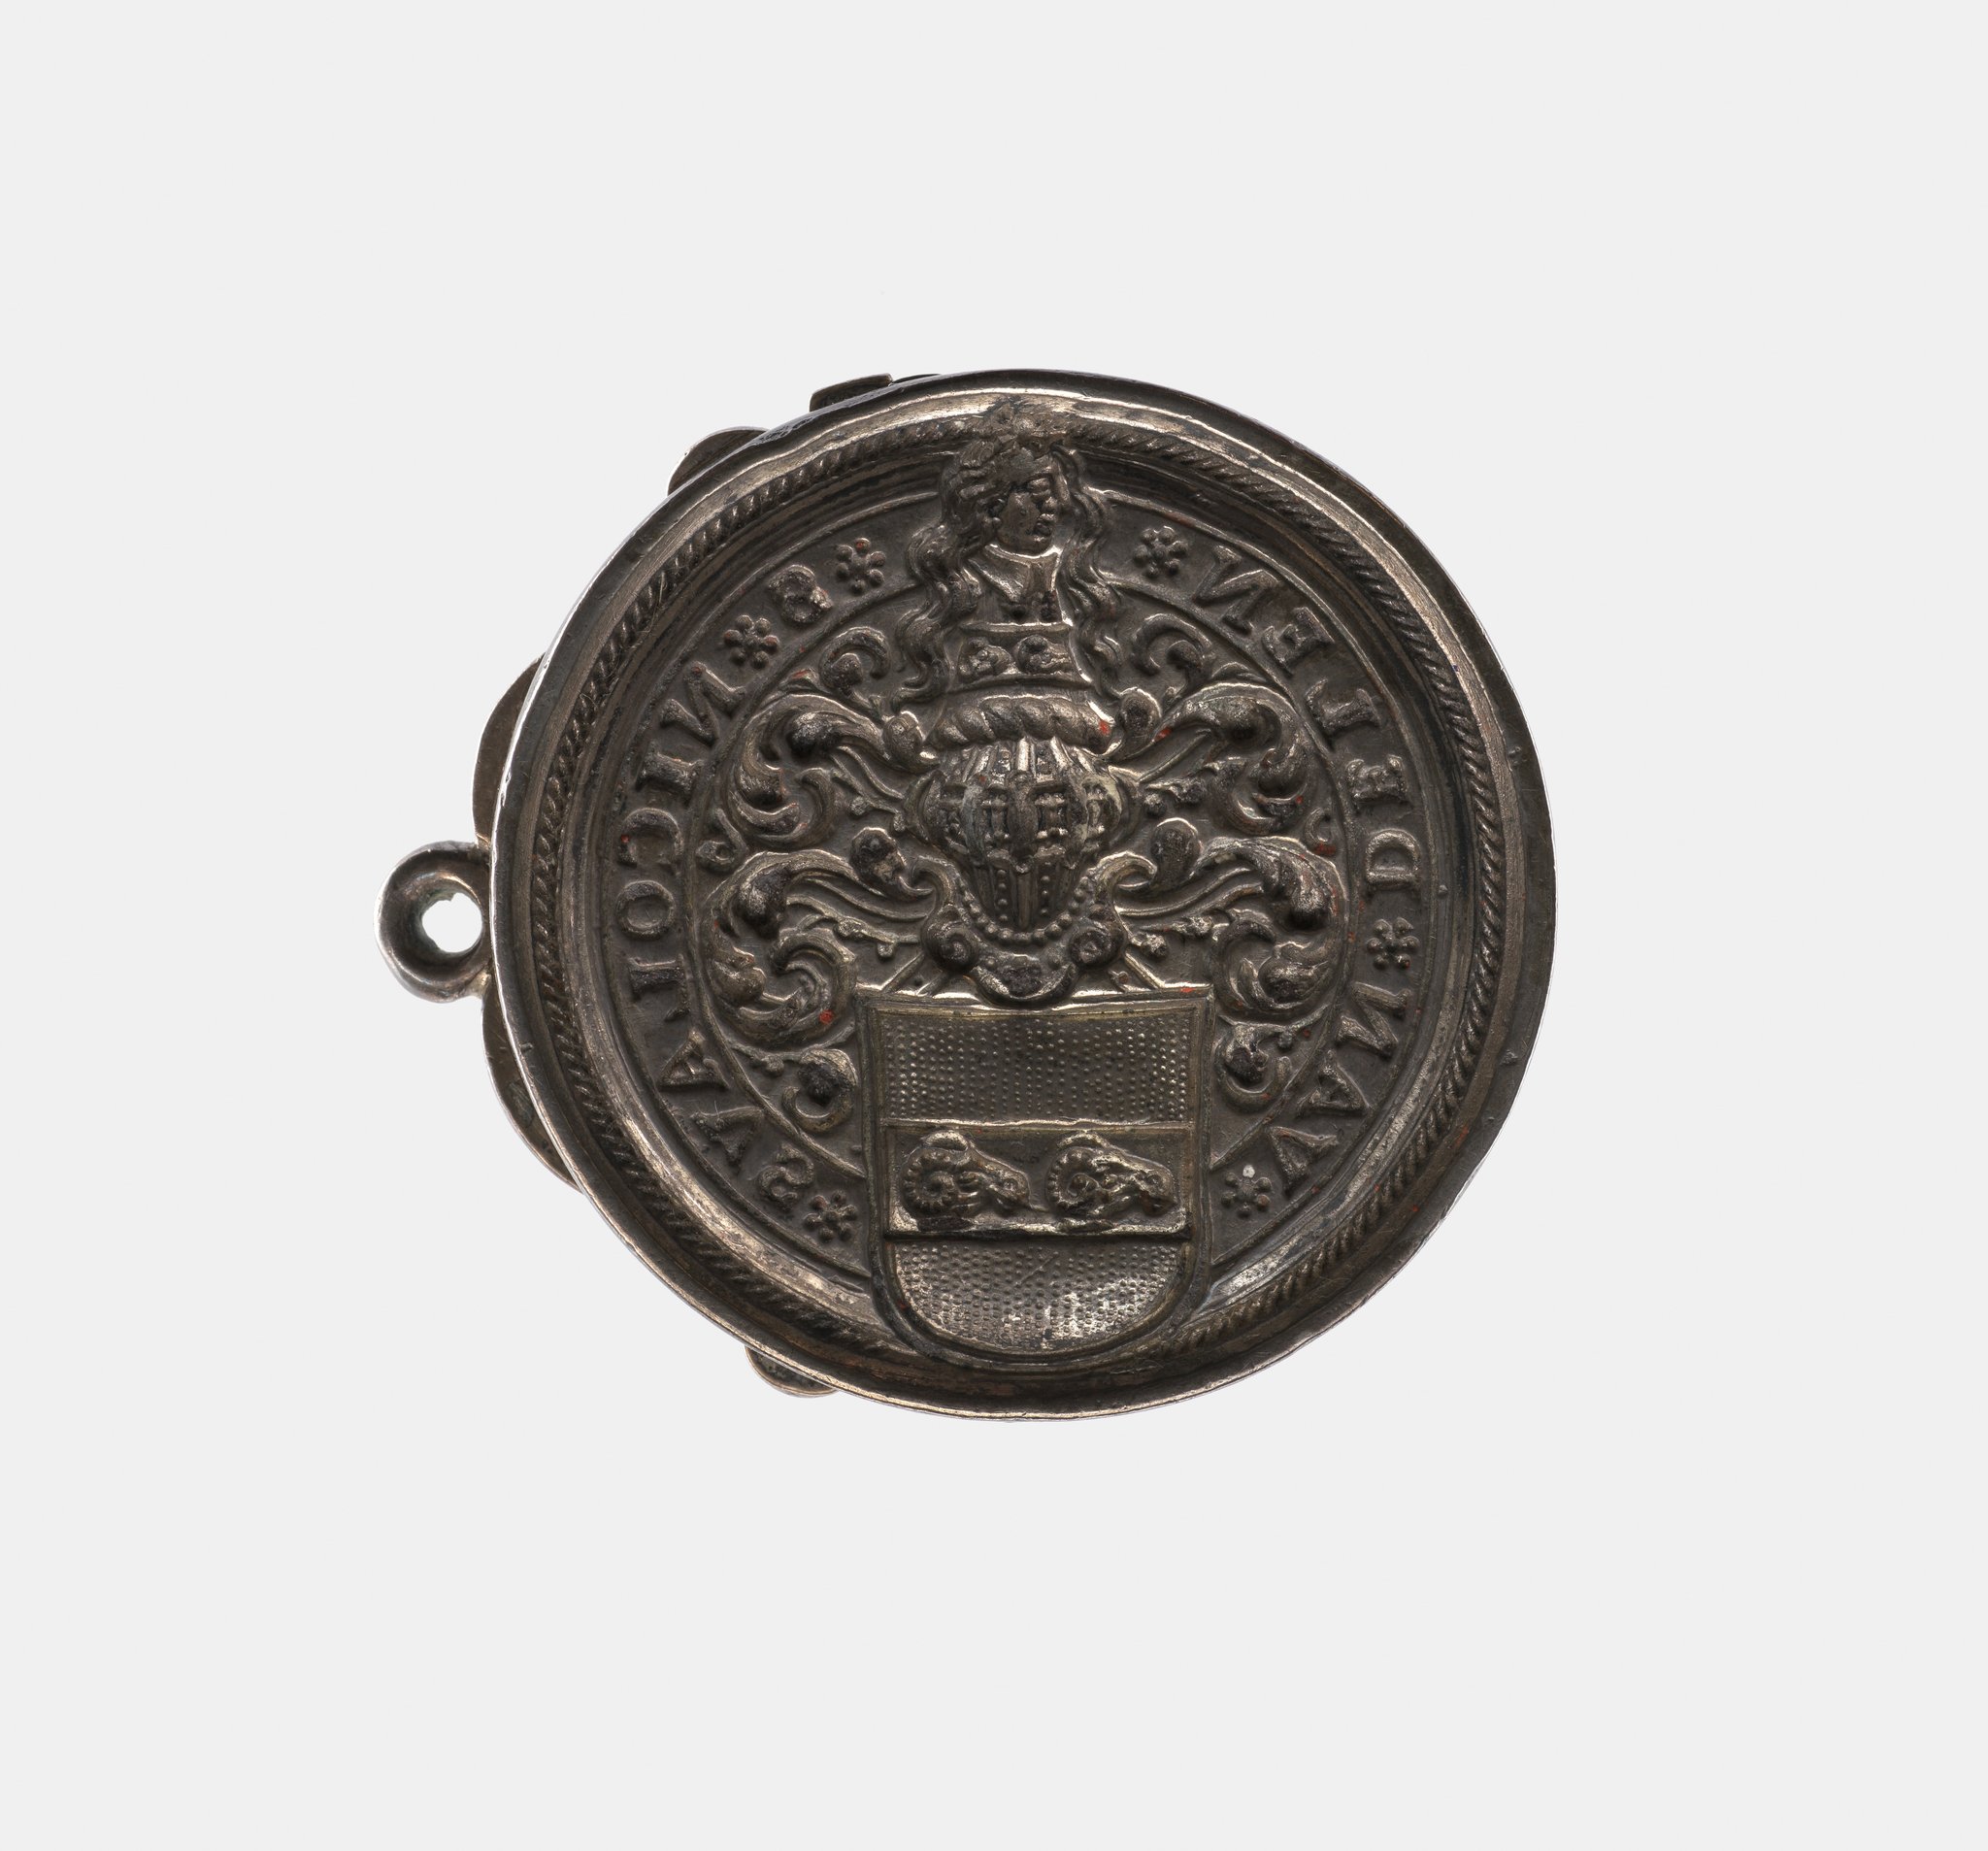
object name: seal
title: Nicholas van Delen, Dutch patrician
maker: Anonymous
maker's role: artist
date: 1601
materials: silver